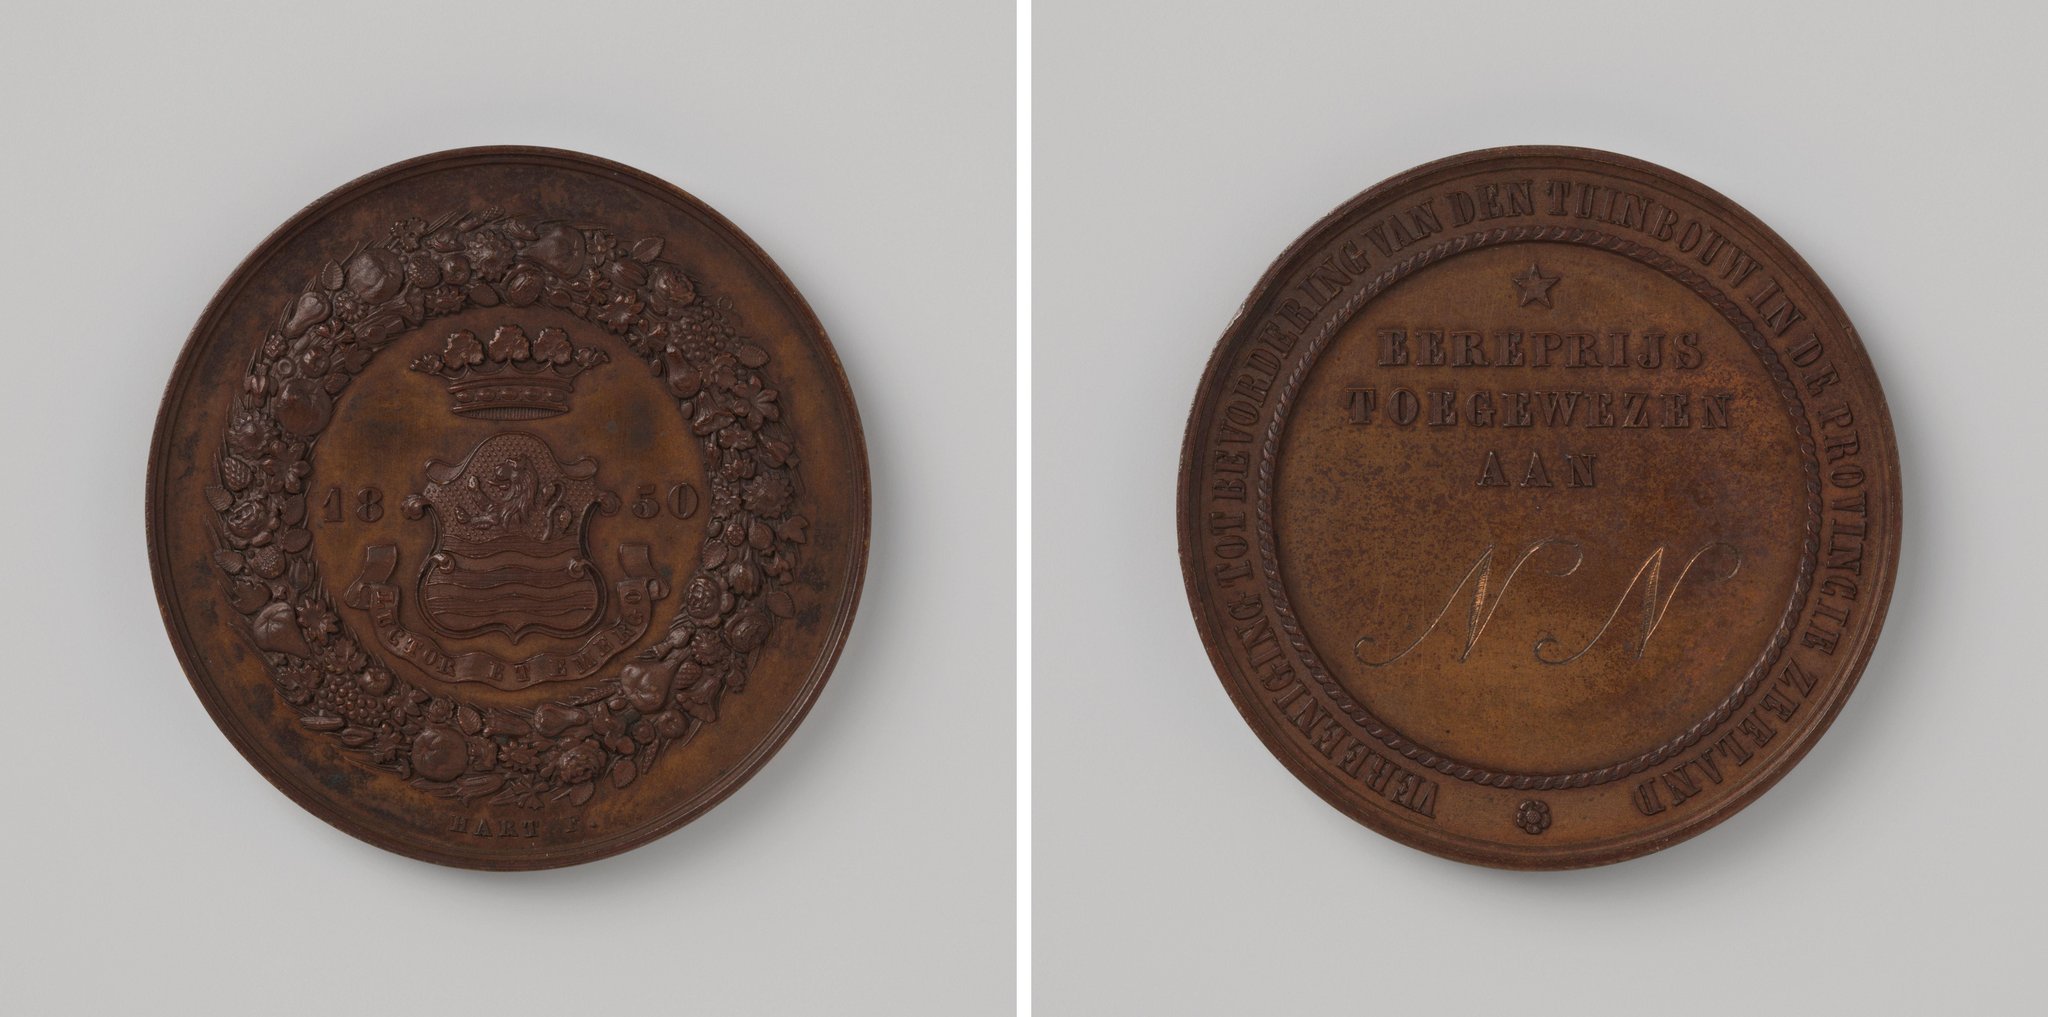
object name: history medal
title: Prijspenning van de Vereeniging tot Bevordering van den Tuinbouw in de Provincie Zeeland 1850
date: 1850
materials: bronze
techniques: engraving, striking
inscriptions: inscription: ‘NN’, inscription: ‘(ster) / EEREPRIJS / TOEGEWEZEN / AAN’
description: Bronzen penning, op de voorzijde het gekroonde ingebogen Zeeuwse wapenschild tussn 18 en 50 boven een lint met de wapenspreuk, alles binnnen een bloemenkrans, op de keerzijde onder een ster drie regels tekst en een inscriptieruimte, met omschrift.